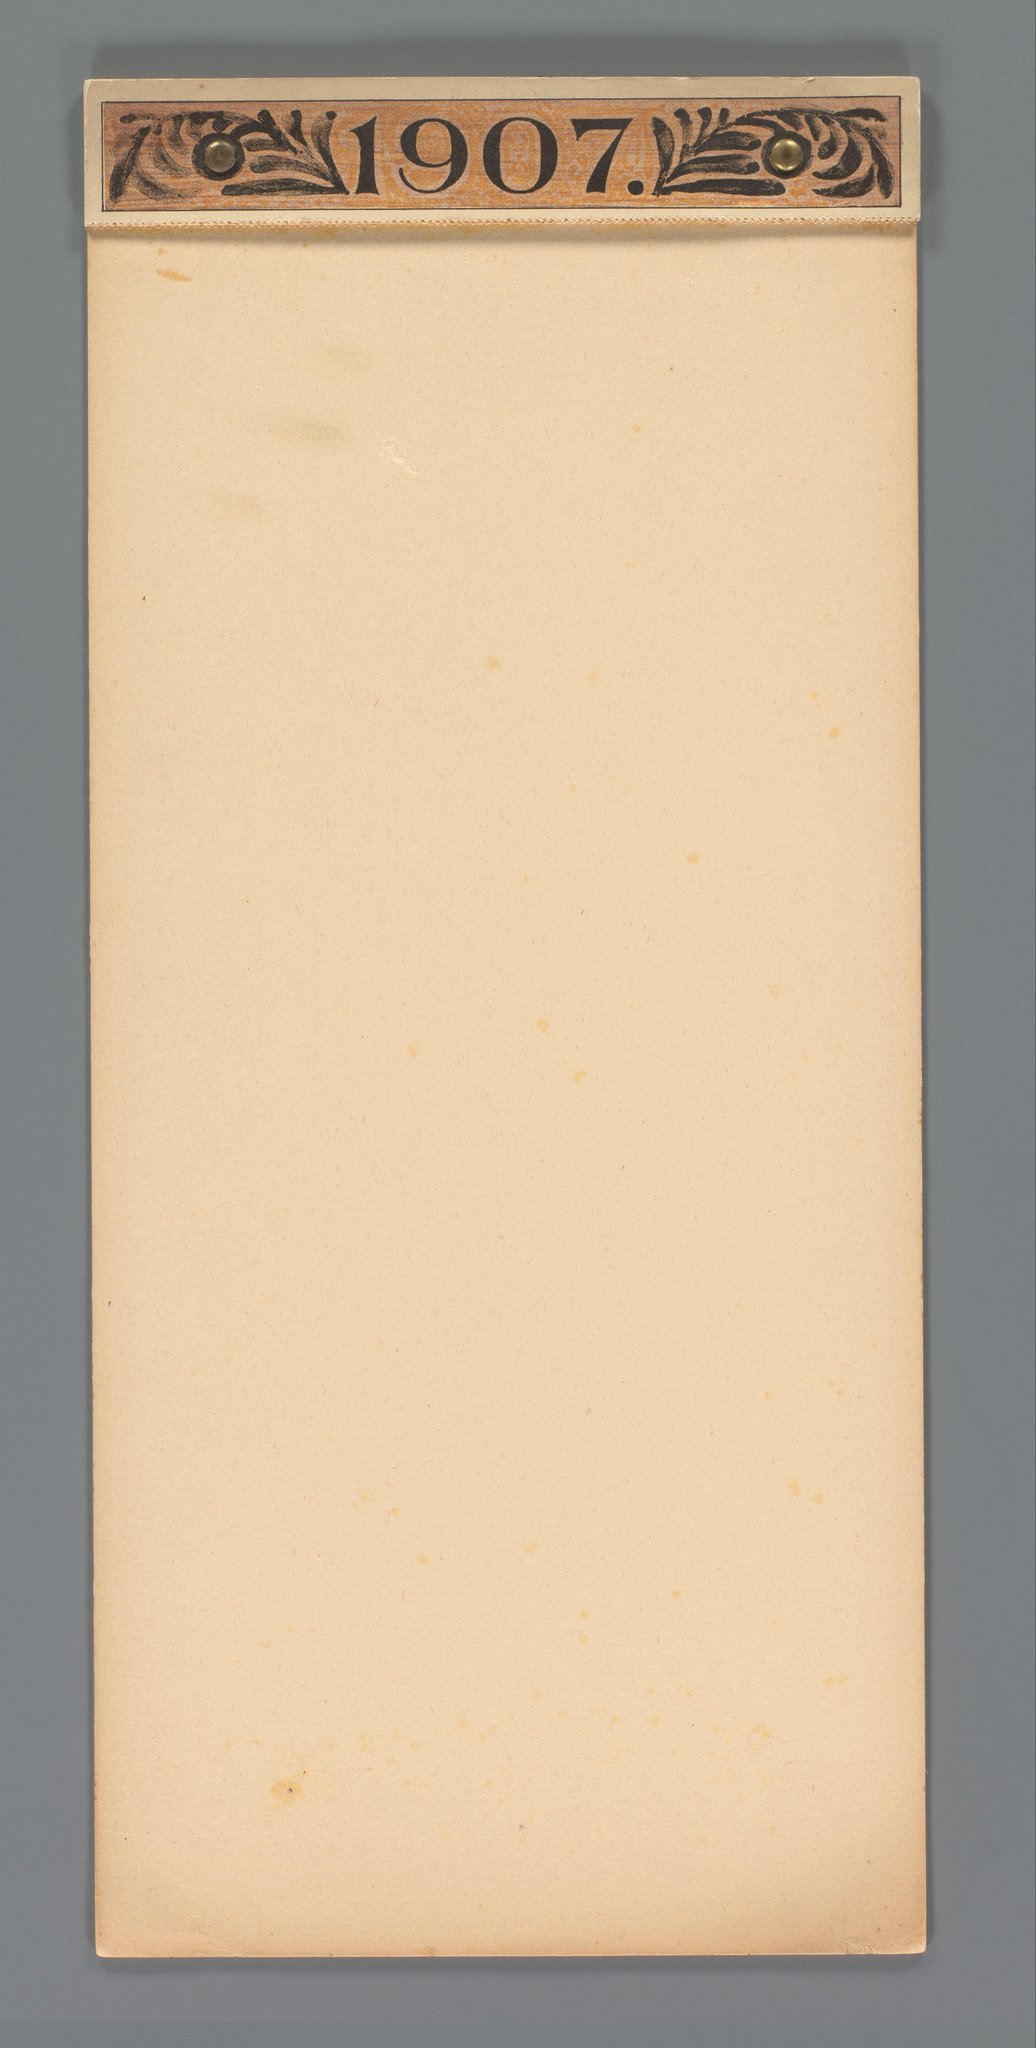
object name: print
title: Kalender voor 1907 met vogels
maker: theo van hoytema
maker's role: draughtsman, painter, print maker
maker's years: 1863-1917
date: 1906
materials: paper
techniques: lithograph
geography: amsterdam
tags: calendar, almanac, birds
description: Incomplete kalender voor 1907, met de maanden april, juni, juli, augustus en september. Op ieder van de bladen één of meerdere vogels, en onder de voorstelling een korte spreuk.